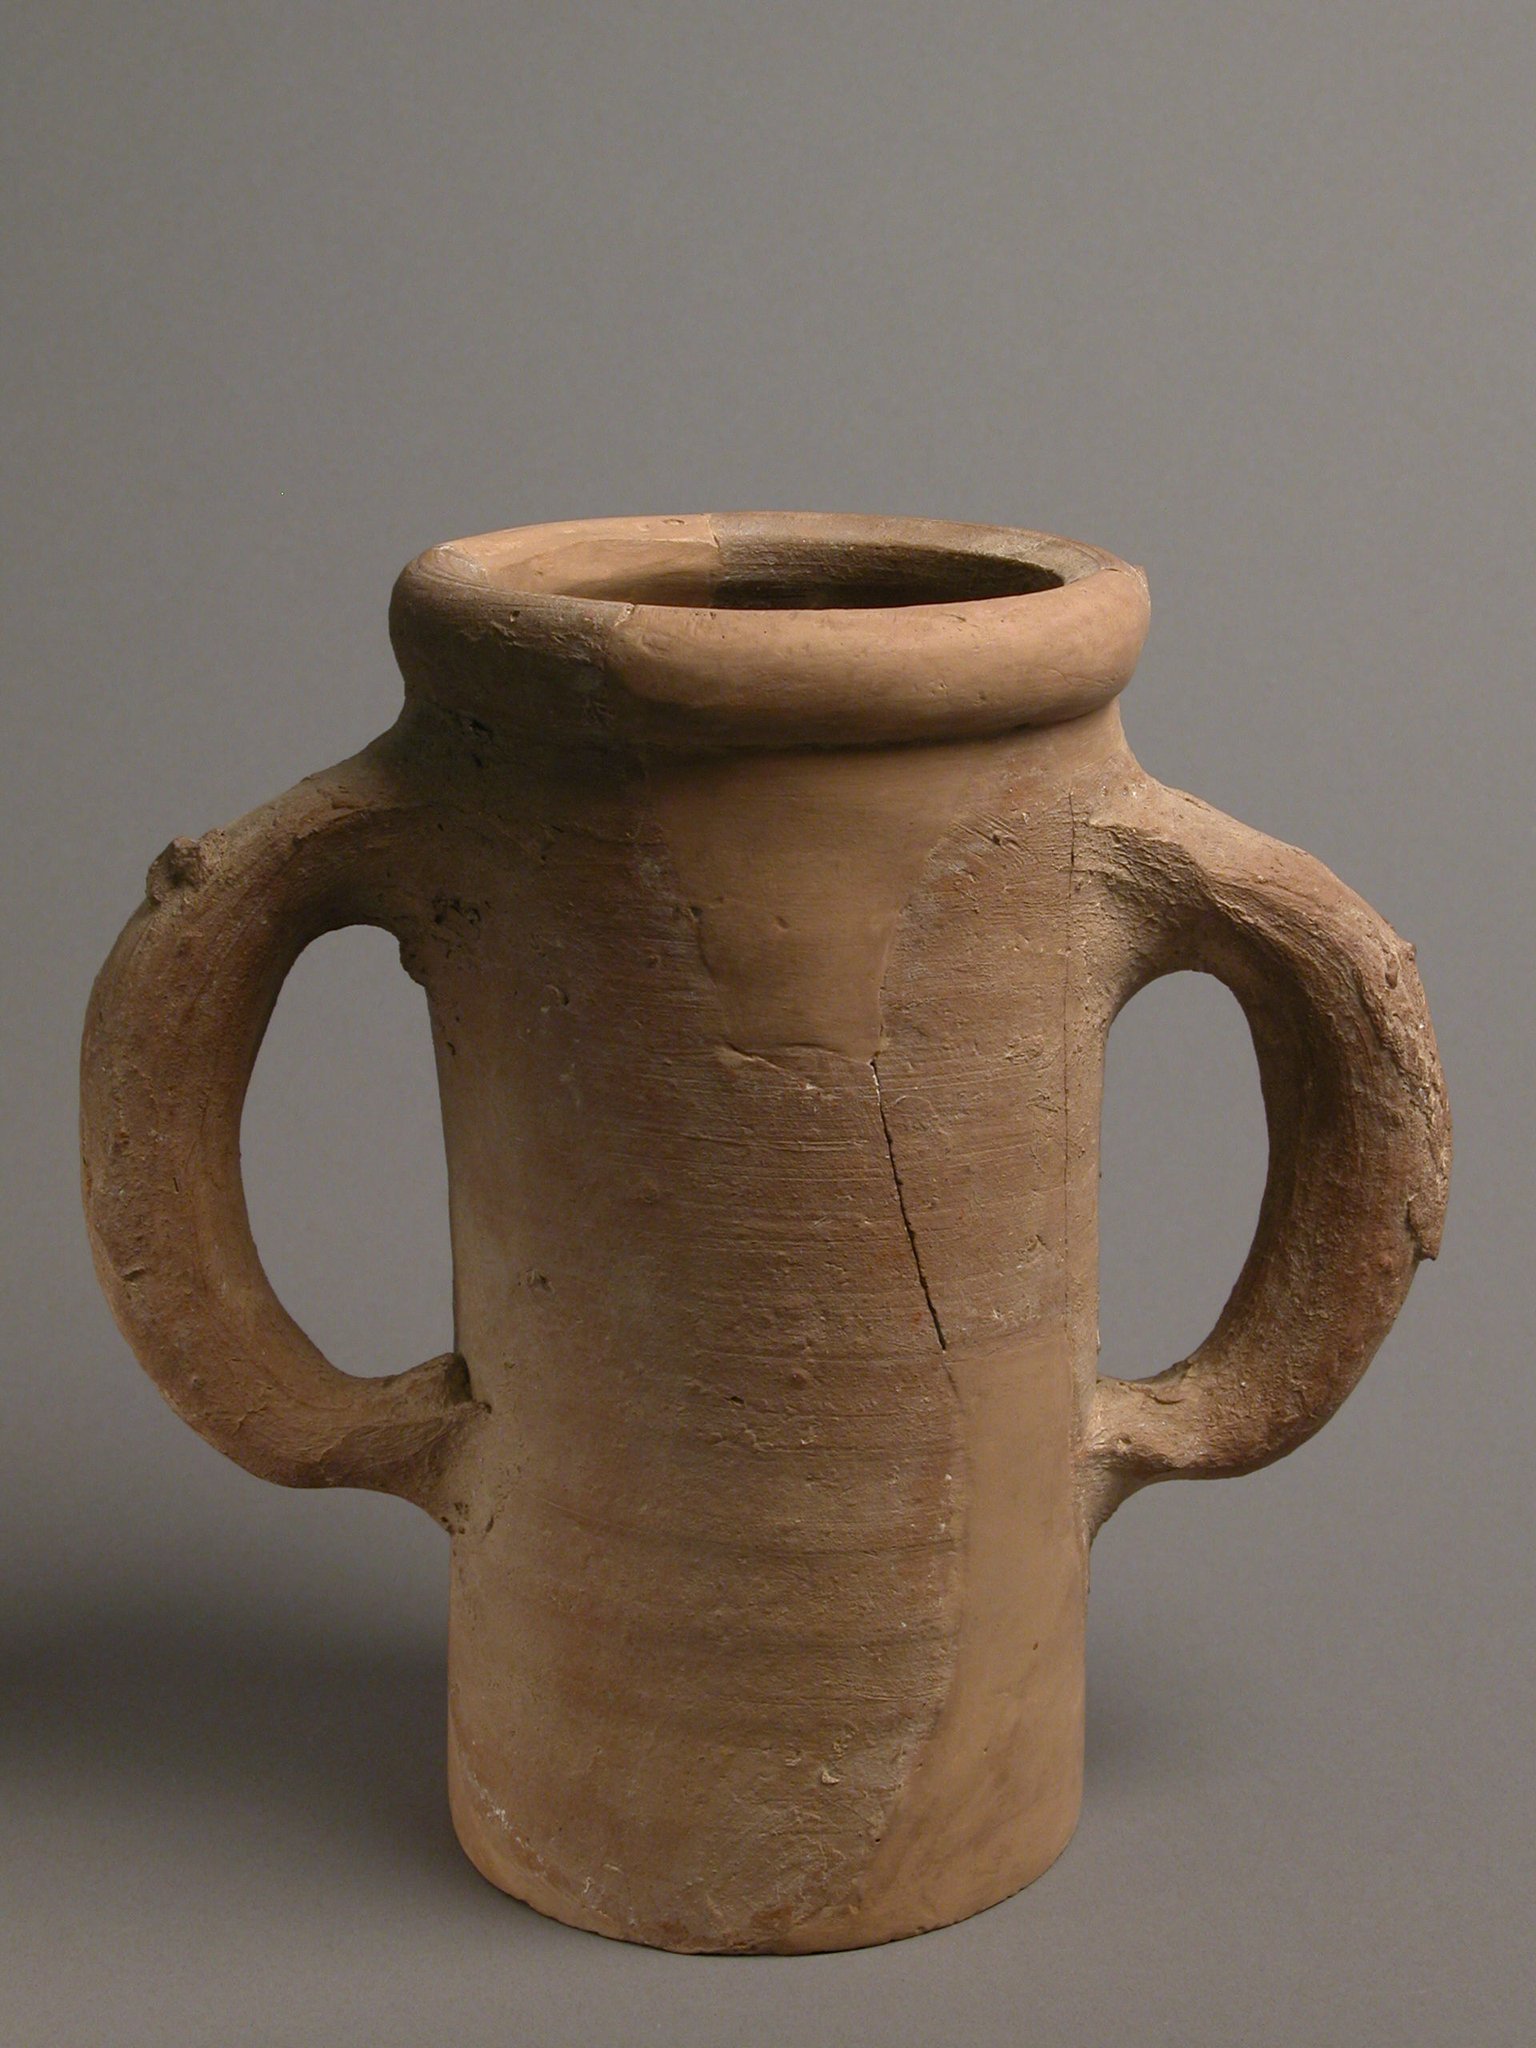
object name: vessel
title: Vessel with Two Handles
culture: coptic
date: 301-700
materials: earthenware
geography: egypt